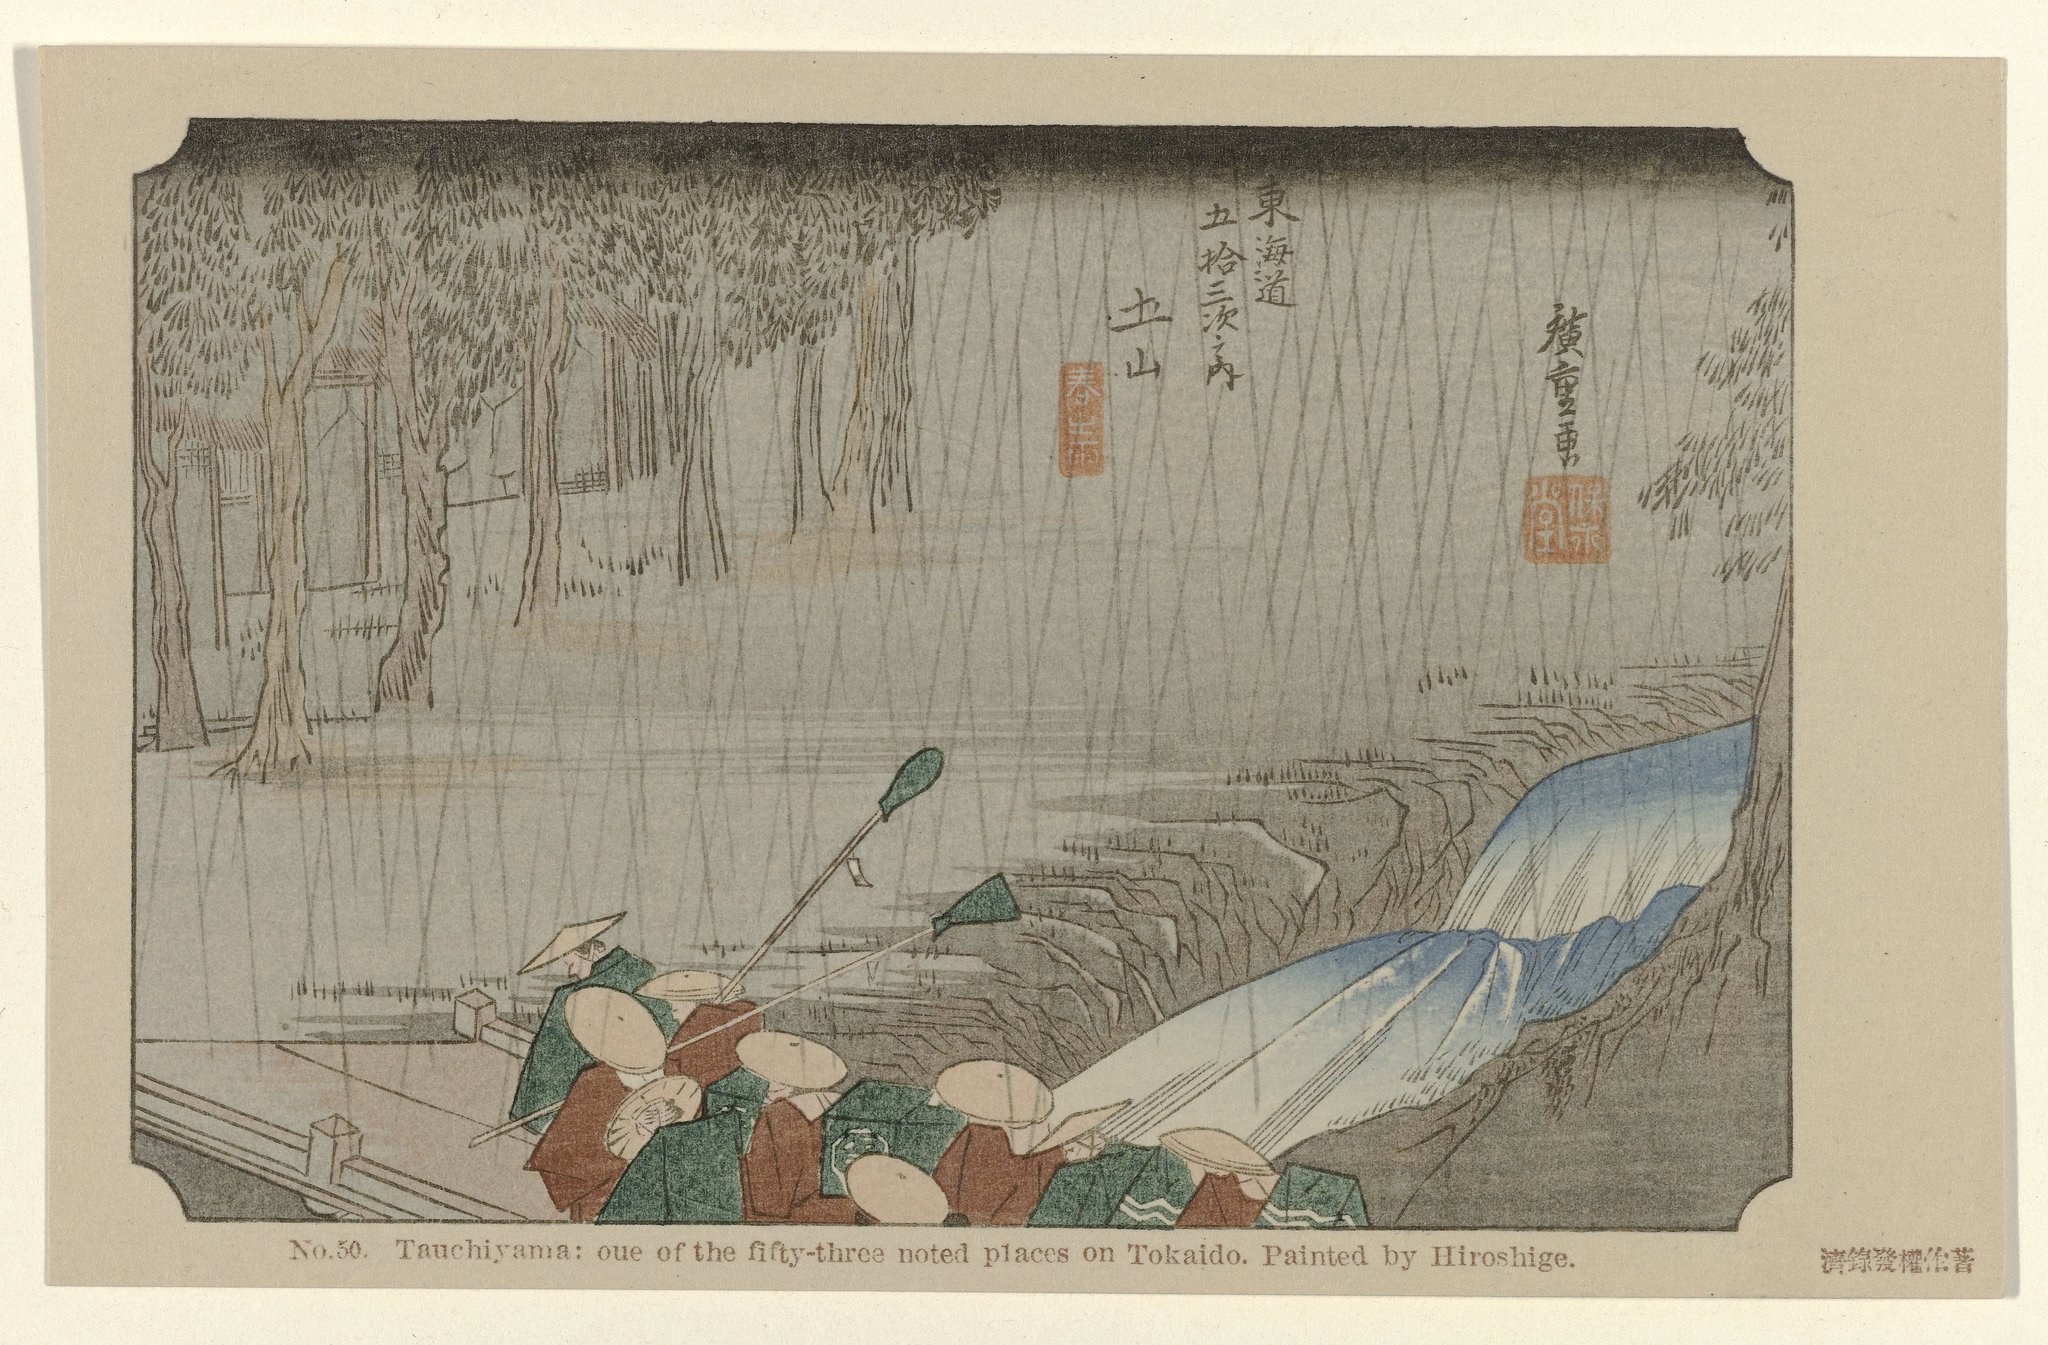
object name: ansichtkaart, prentbriefkaart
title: Hiroshige no fude Tôkaidô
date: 1906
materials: cardboard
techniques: woodcut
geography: japan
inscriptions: date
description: Een processie van een krijgsheer (daimyo) steekt een brug over tijdens een regenbui.